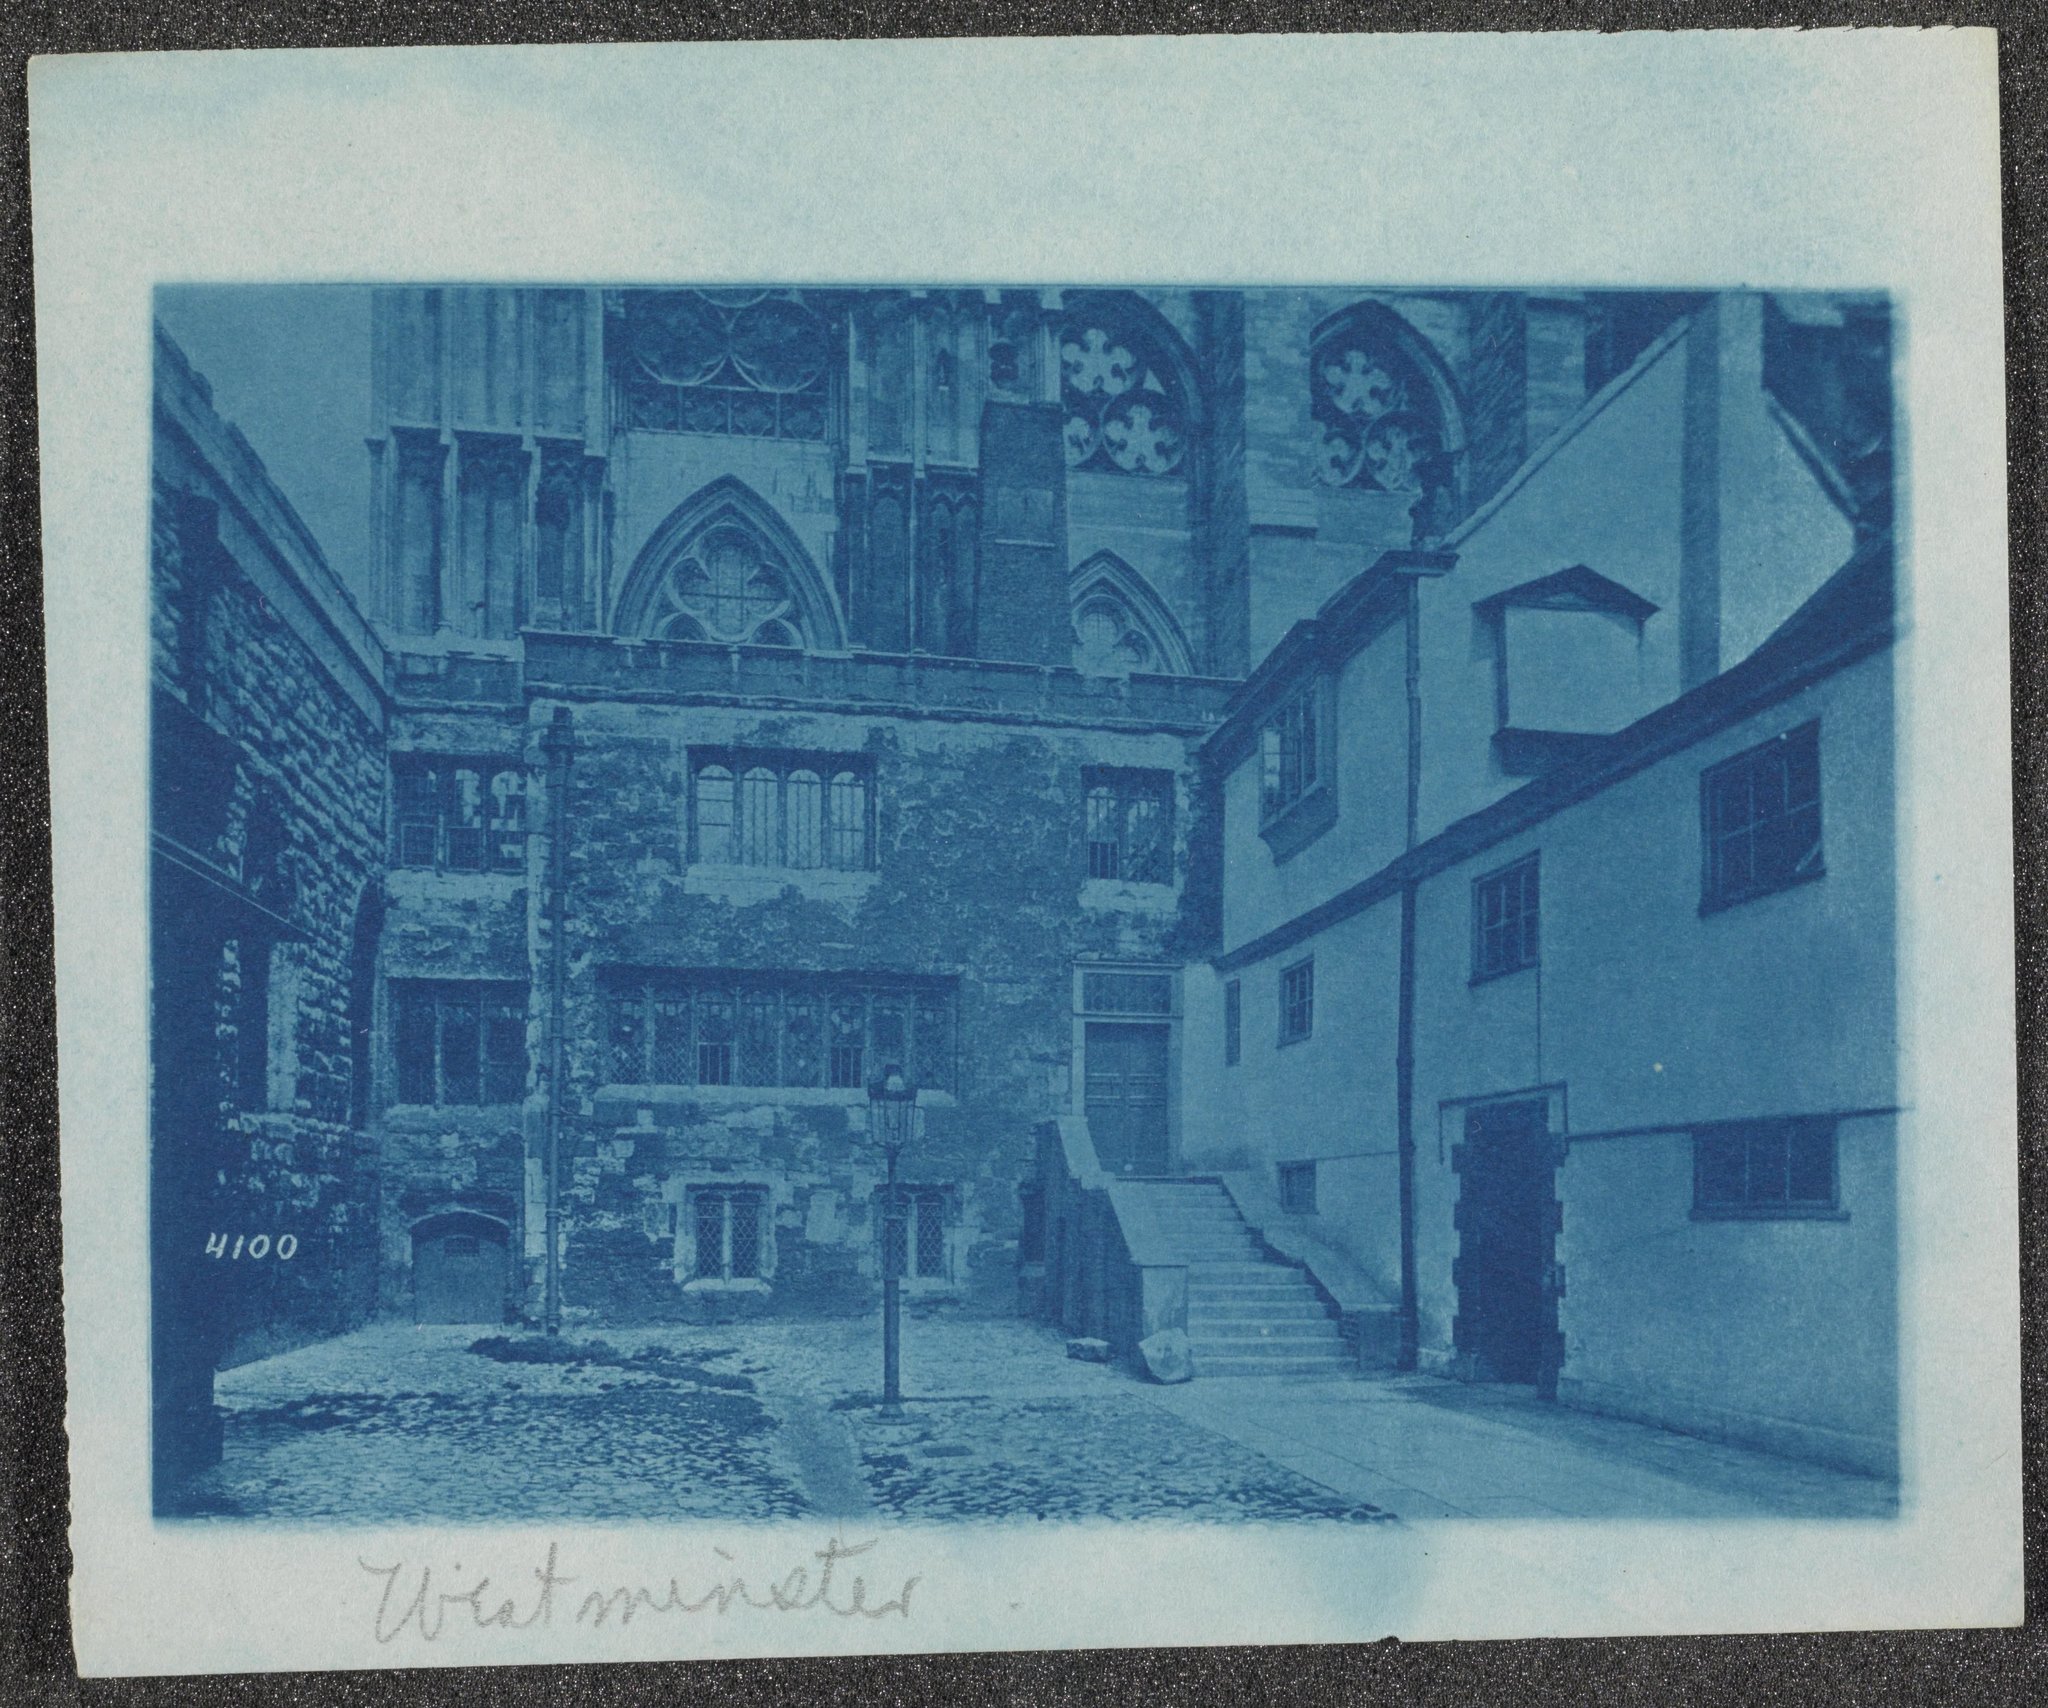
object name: photograph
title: Gevel van Westminster Abbey in Londen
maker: Anonymous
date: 1890-1905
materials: photographic support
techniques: cyanotype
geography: london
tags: parts of church exterior and annexes: façade, westminster abbey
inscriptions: number: ‘4100’